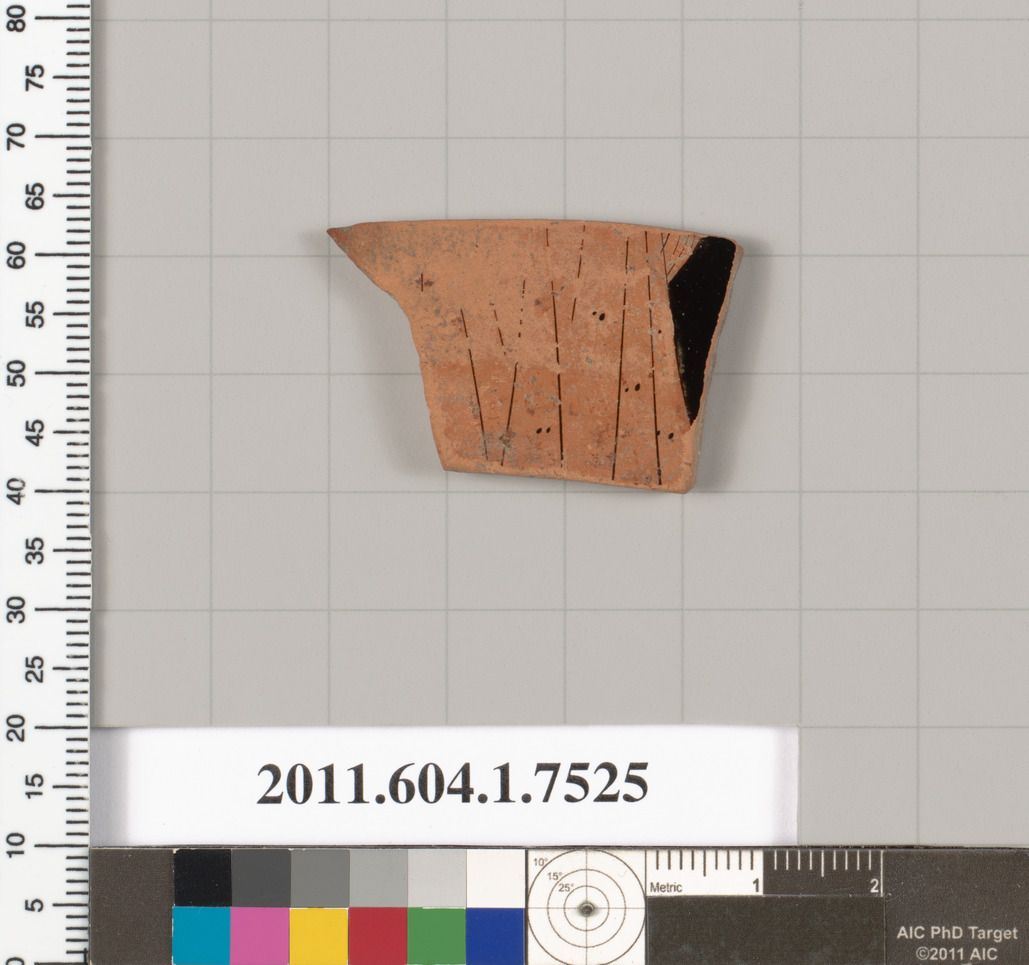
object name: kylix fragment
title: Terracotta fragment of a kylix (drinking cup)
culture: greek, attic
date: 460-450 BCE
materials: terracotta